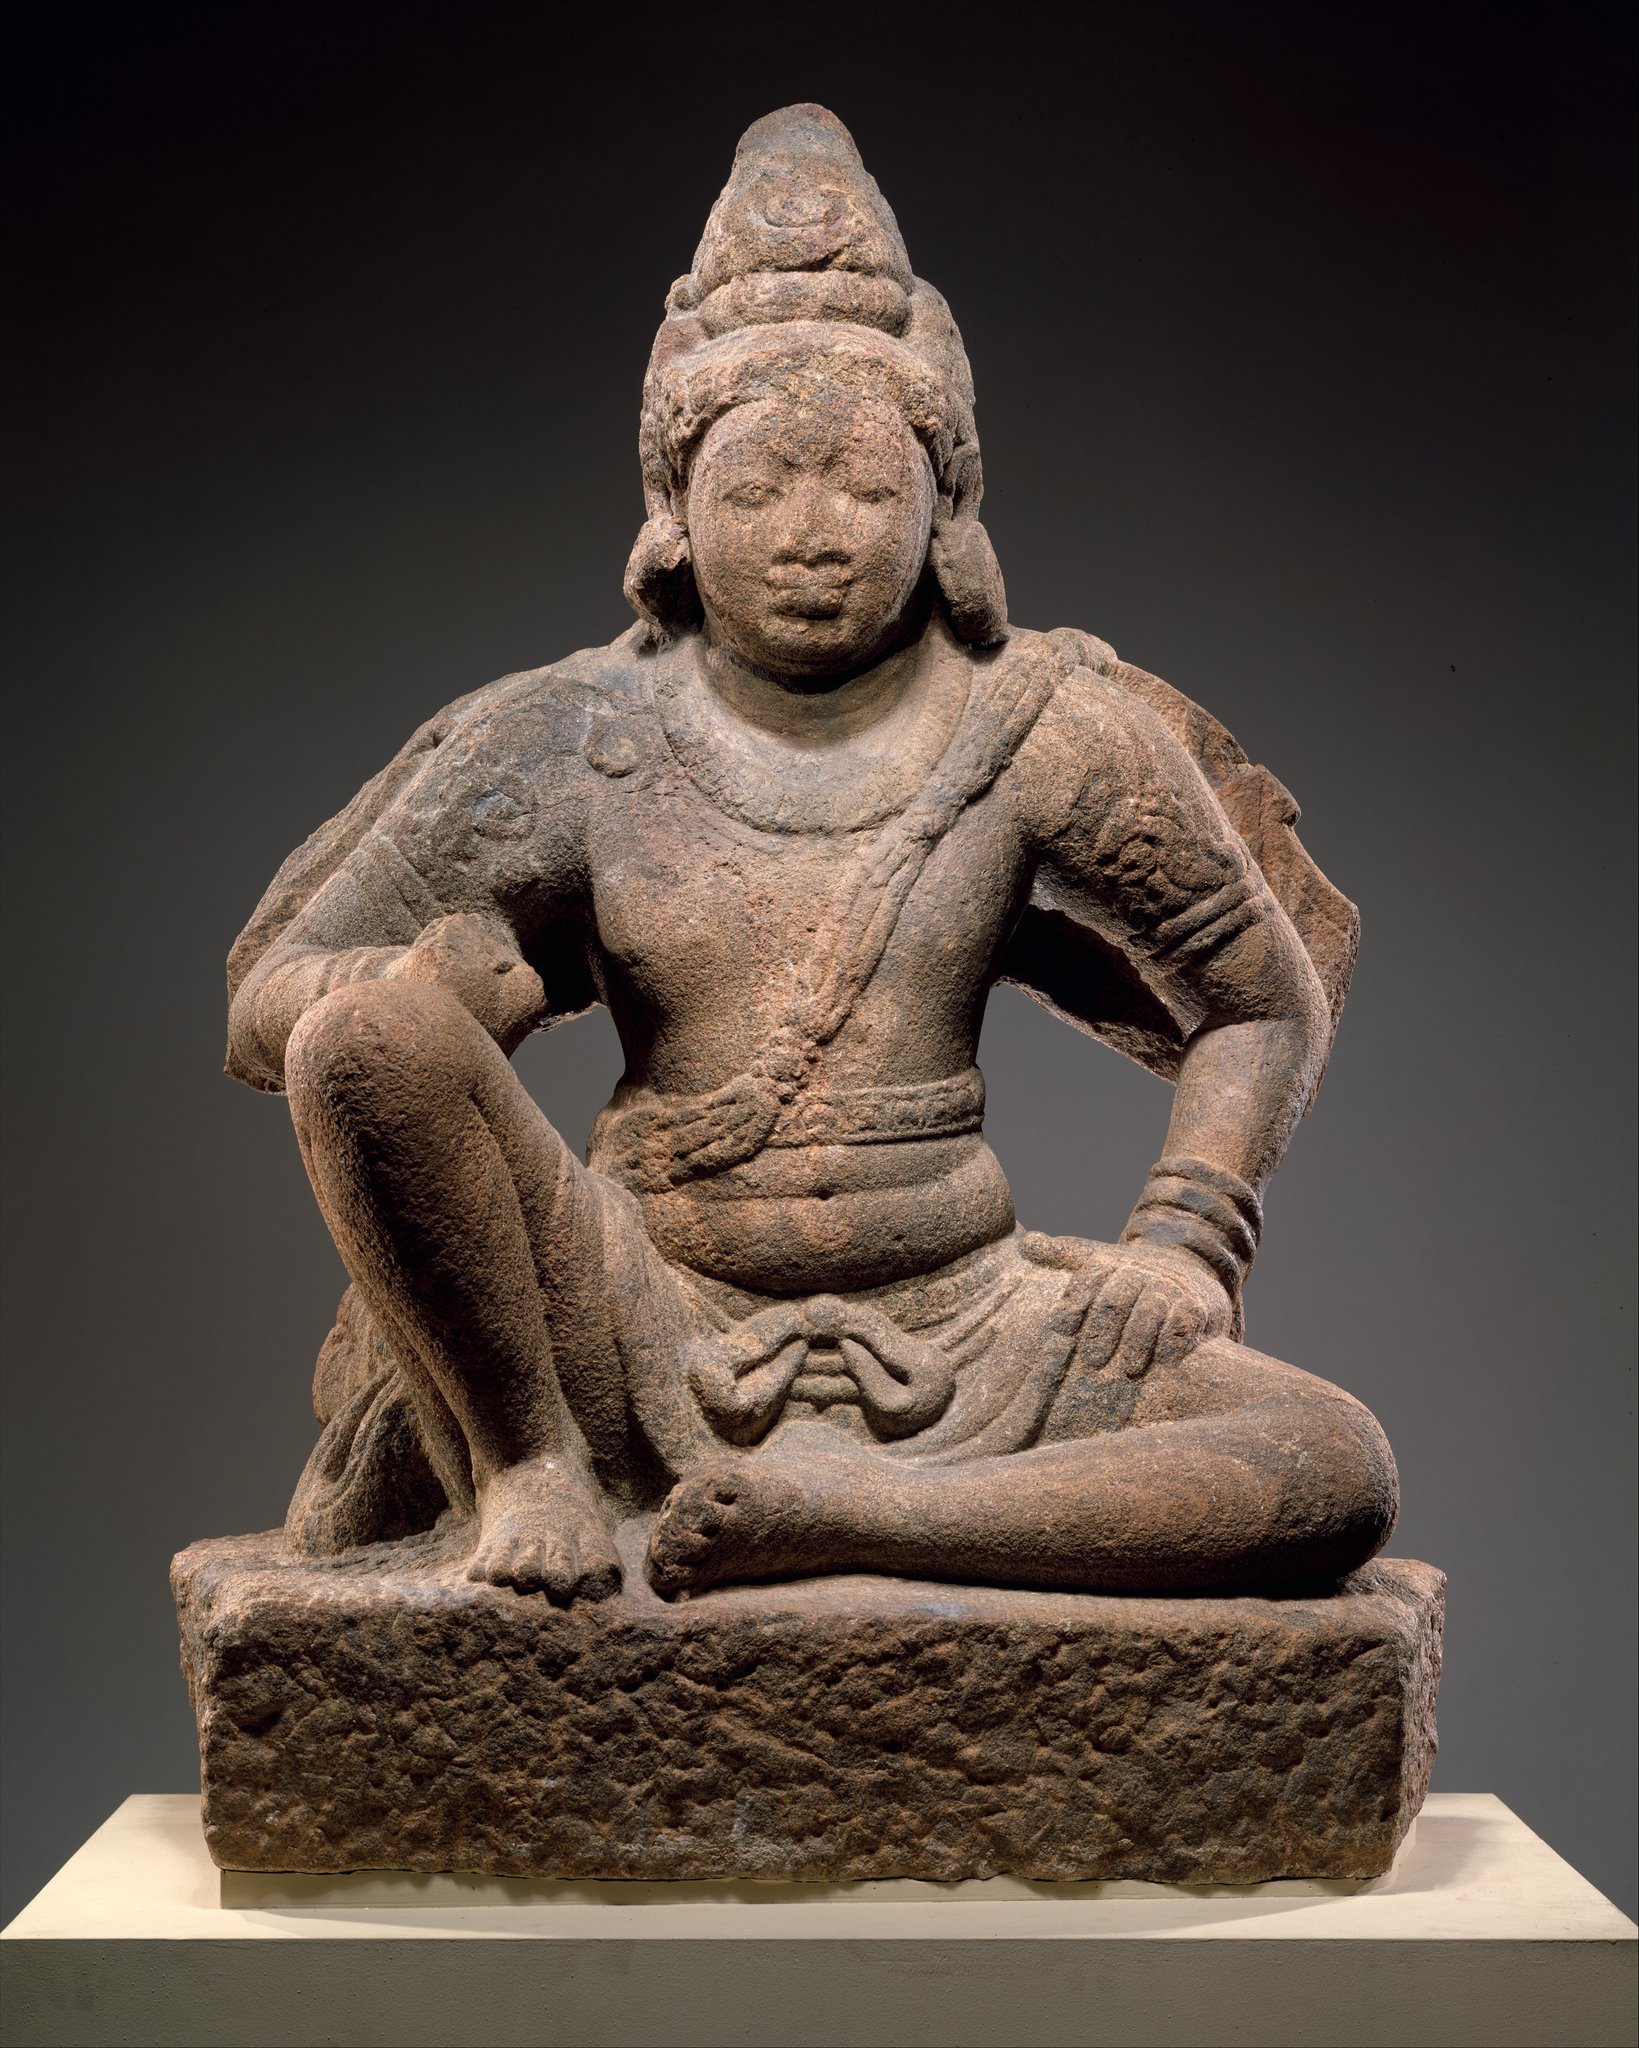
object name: figure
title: Garuda (Vishnu's Mount) Seated in Royal Ease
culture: tamil nadu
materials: granite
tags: birds,hinduism